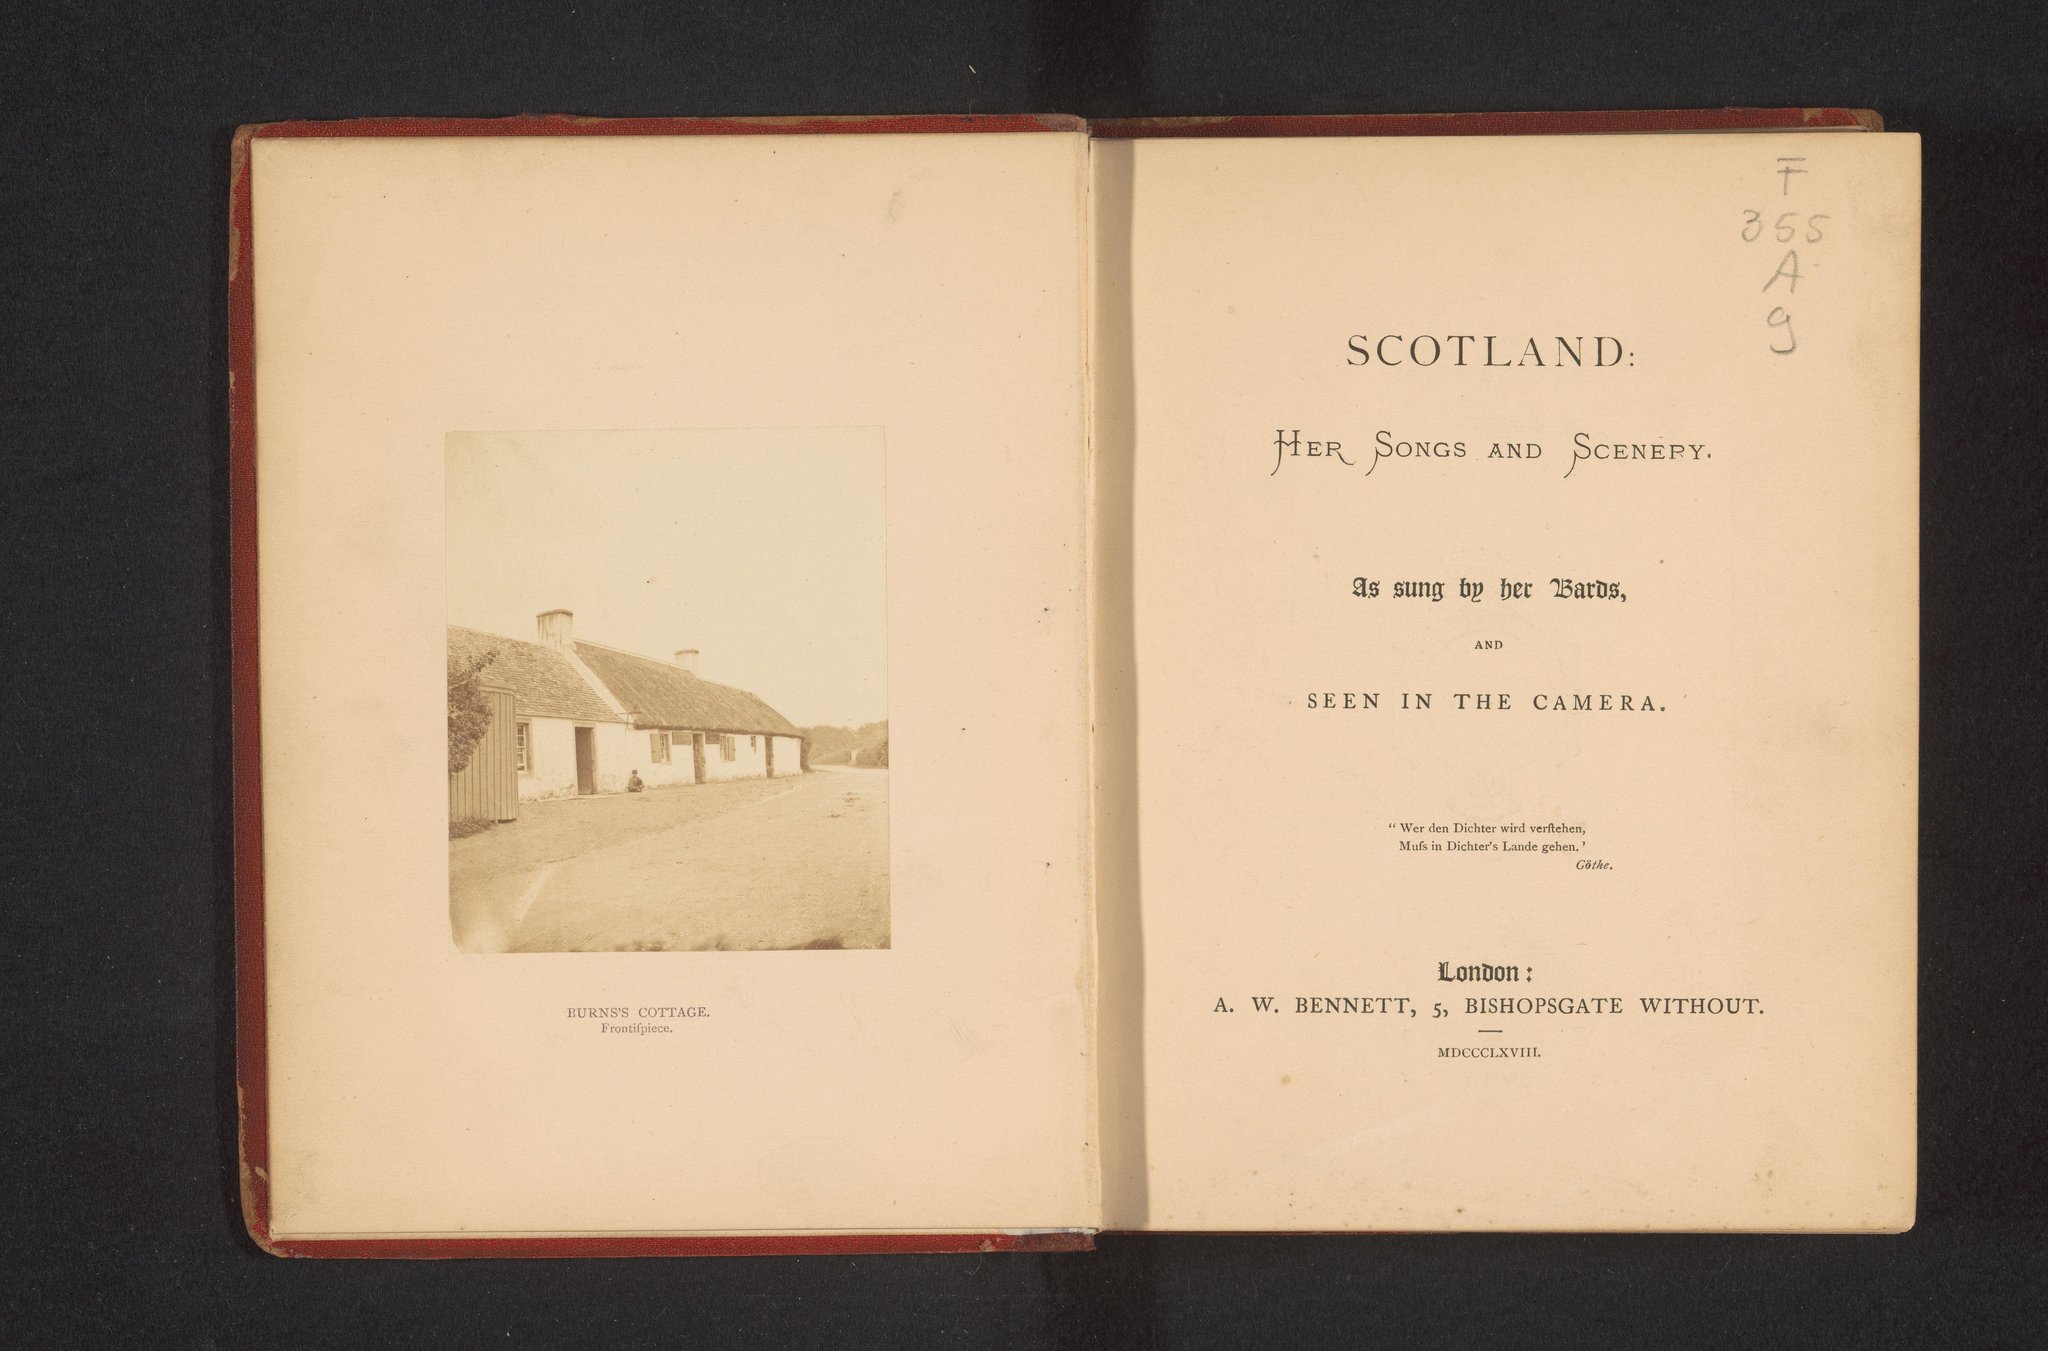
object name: book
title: Scotland: her songs and scenery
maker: alfred william bennett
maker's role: publisher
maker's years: 1833-1902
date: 1868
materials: cardboard, linen, paper, photographic support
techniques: albumen print, printing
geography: london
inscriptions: inscription: ‘Miss A.D. Gibson’